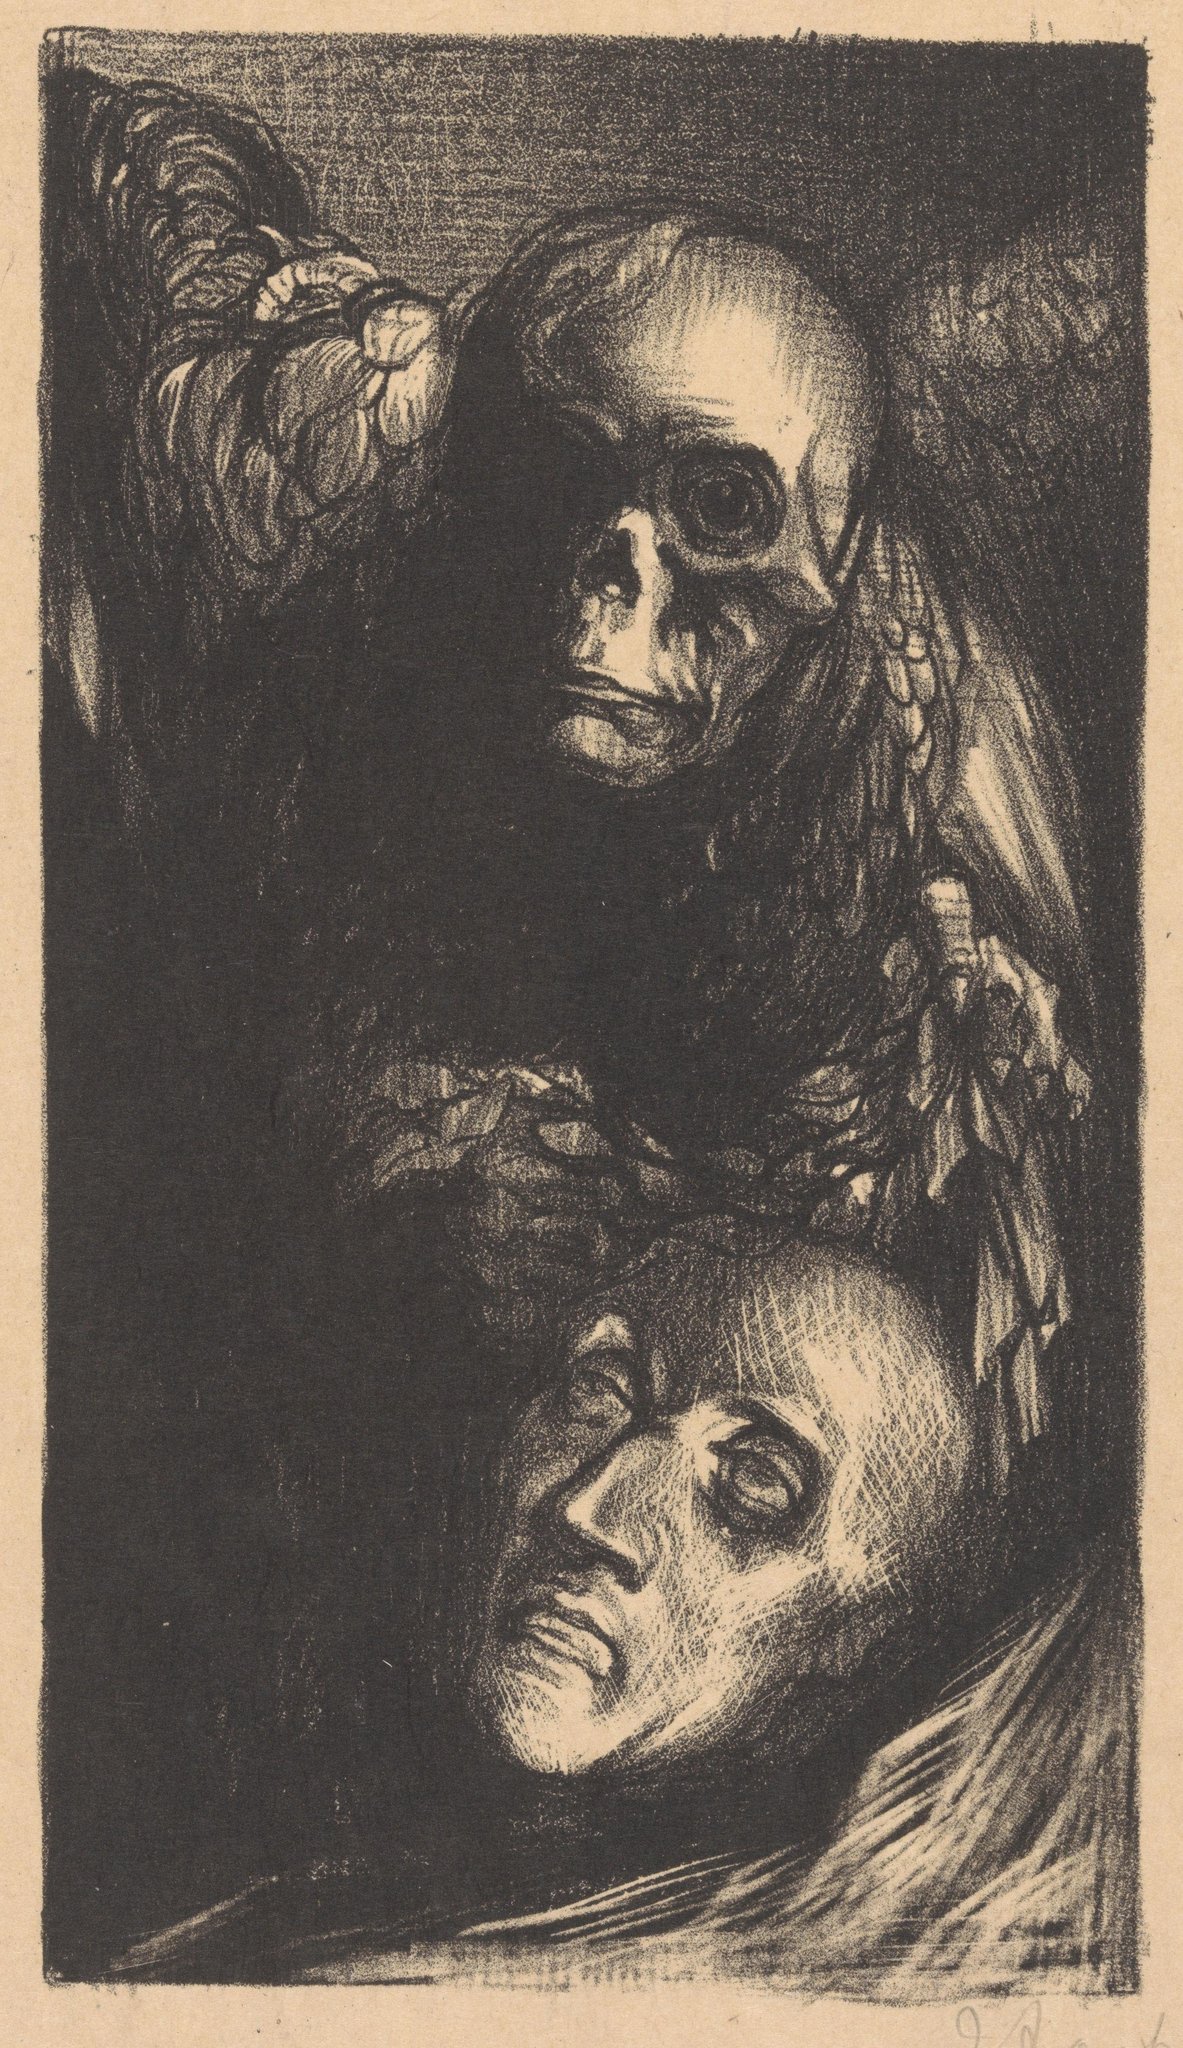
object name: print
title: De Dood met afgehakt hoofd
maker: johannes josephus aarts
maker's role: draughtsman, print maker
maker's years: 1871-1934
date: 1927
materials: paper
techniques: lithograph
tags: personifications of death; 'morte' (ripa), head of a beheaded person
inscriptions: collector's mark: Lugt 2228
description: Een figuur met een doodshoofd bij een afgehakt hoofd met open ogen.